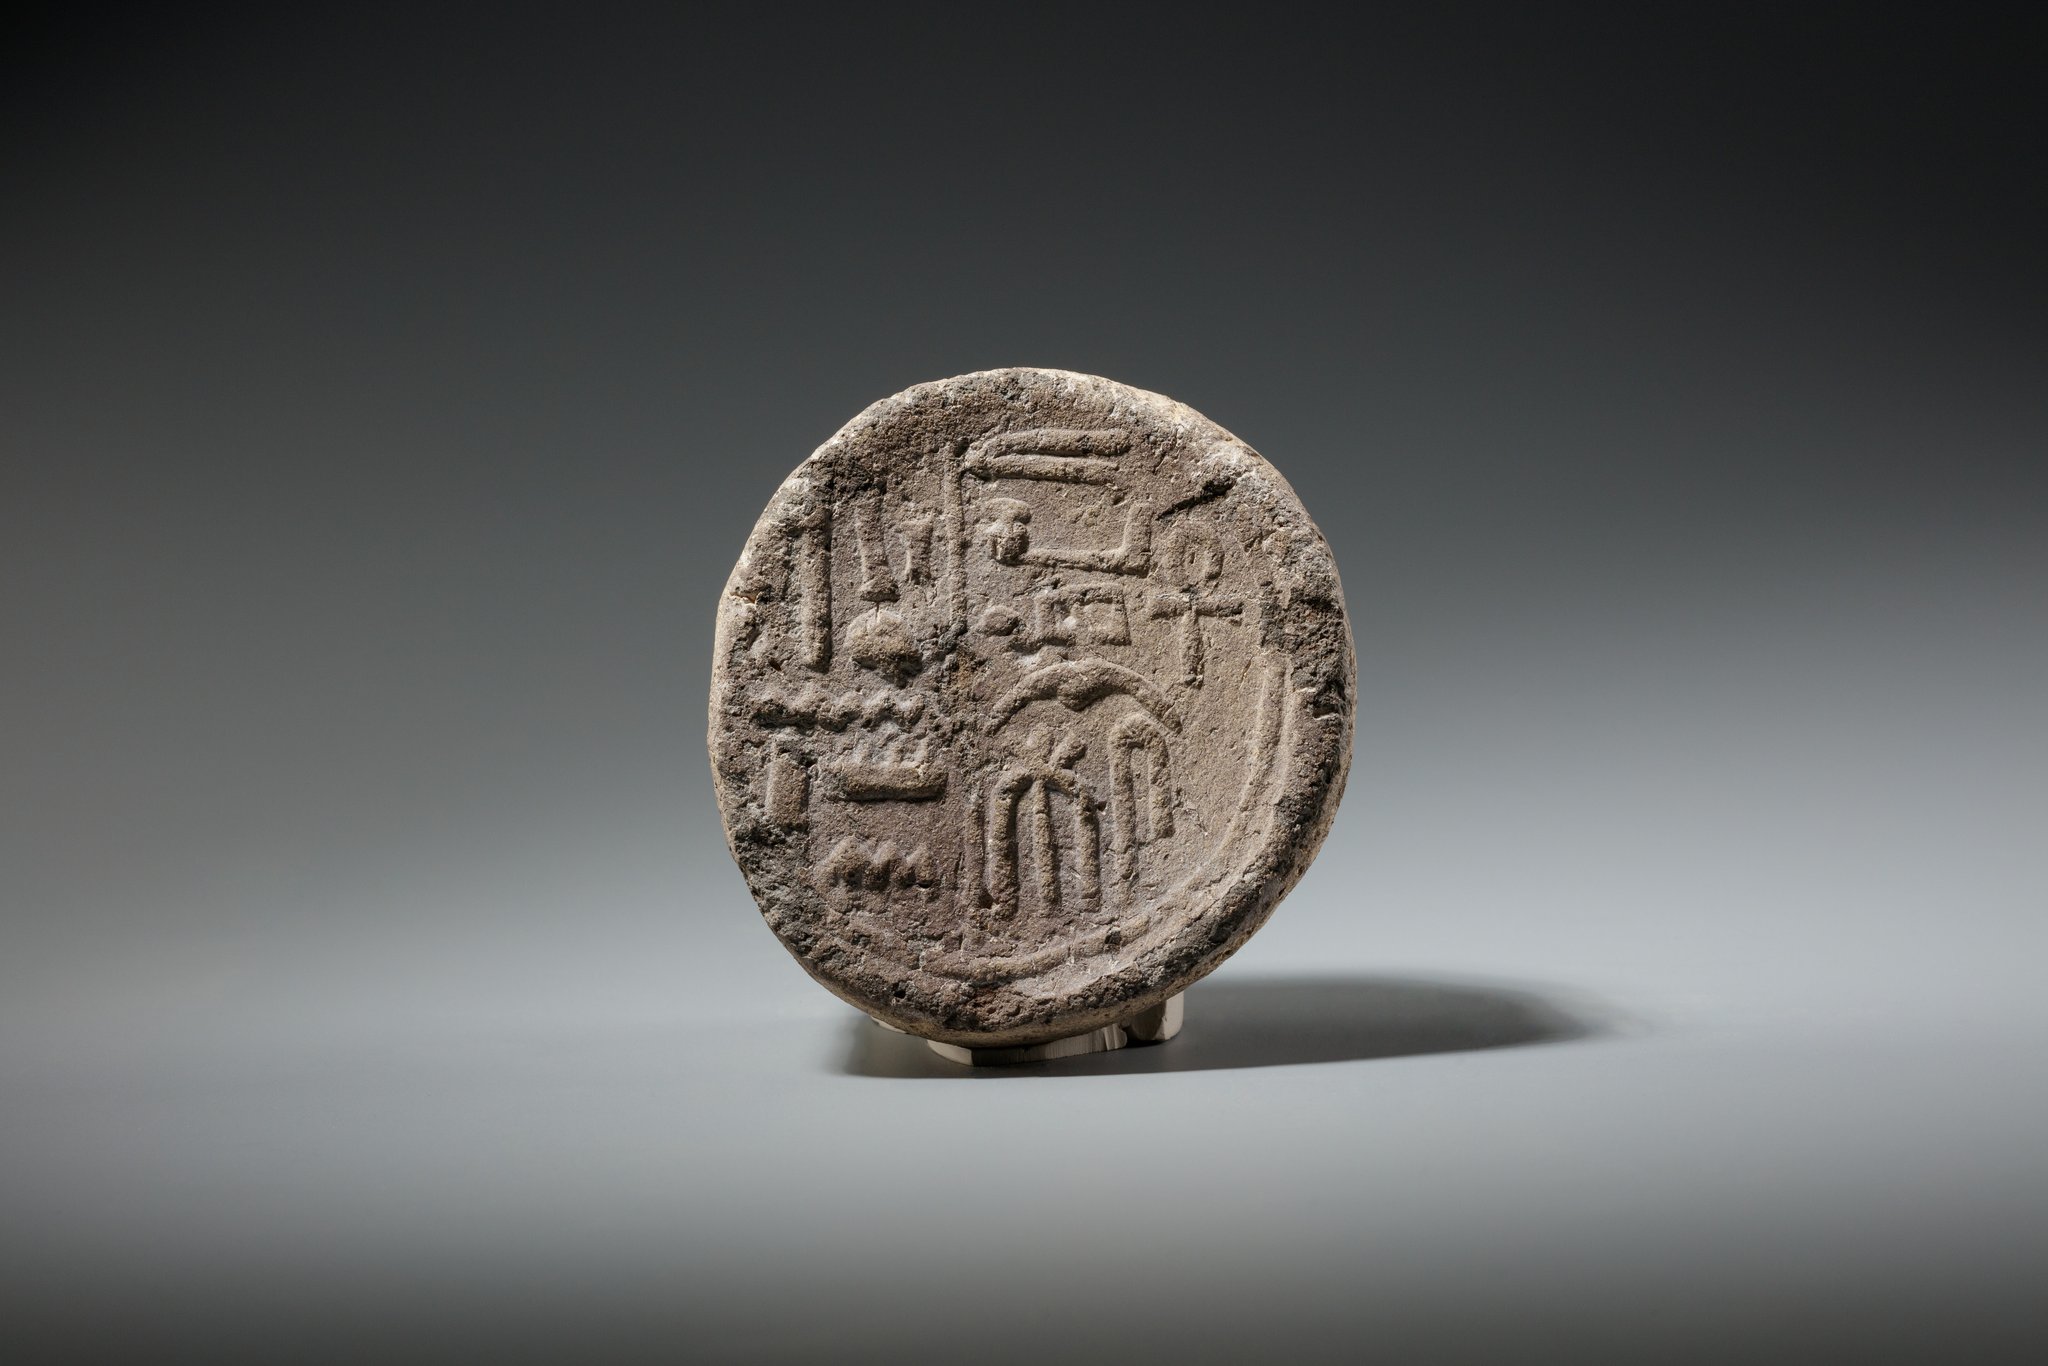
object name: cone, ahmose, tt 121, circular impression, prophet, amun, thutmose iii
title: Funerary Cone of Ahmose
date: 1479-1425 BCE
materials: pottery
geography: egypt